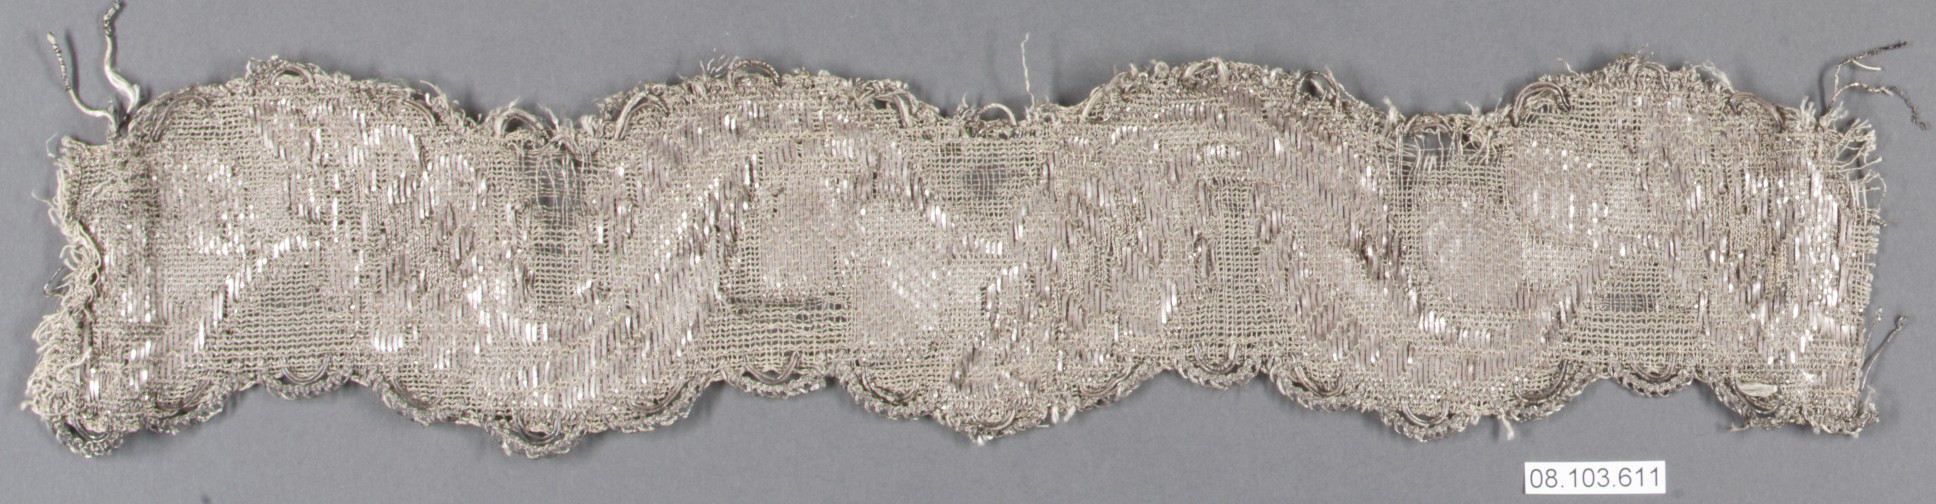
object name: galloon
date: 1701-1800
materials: metal thread, silk